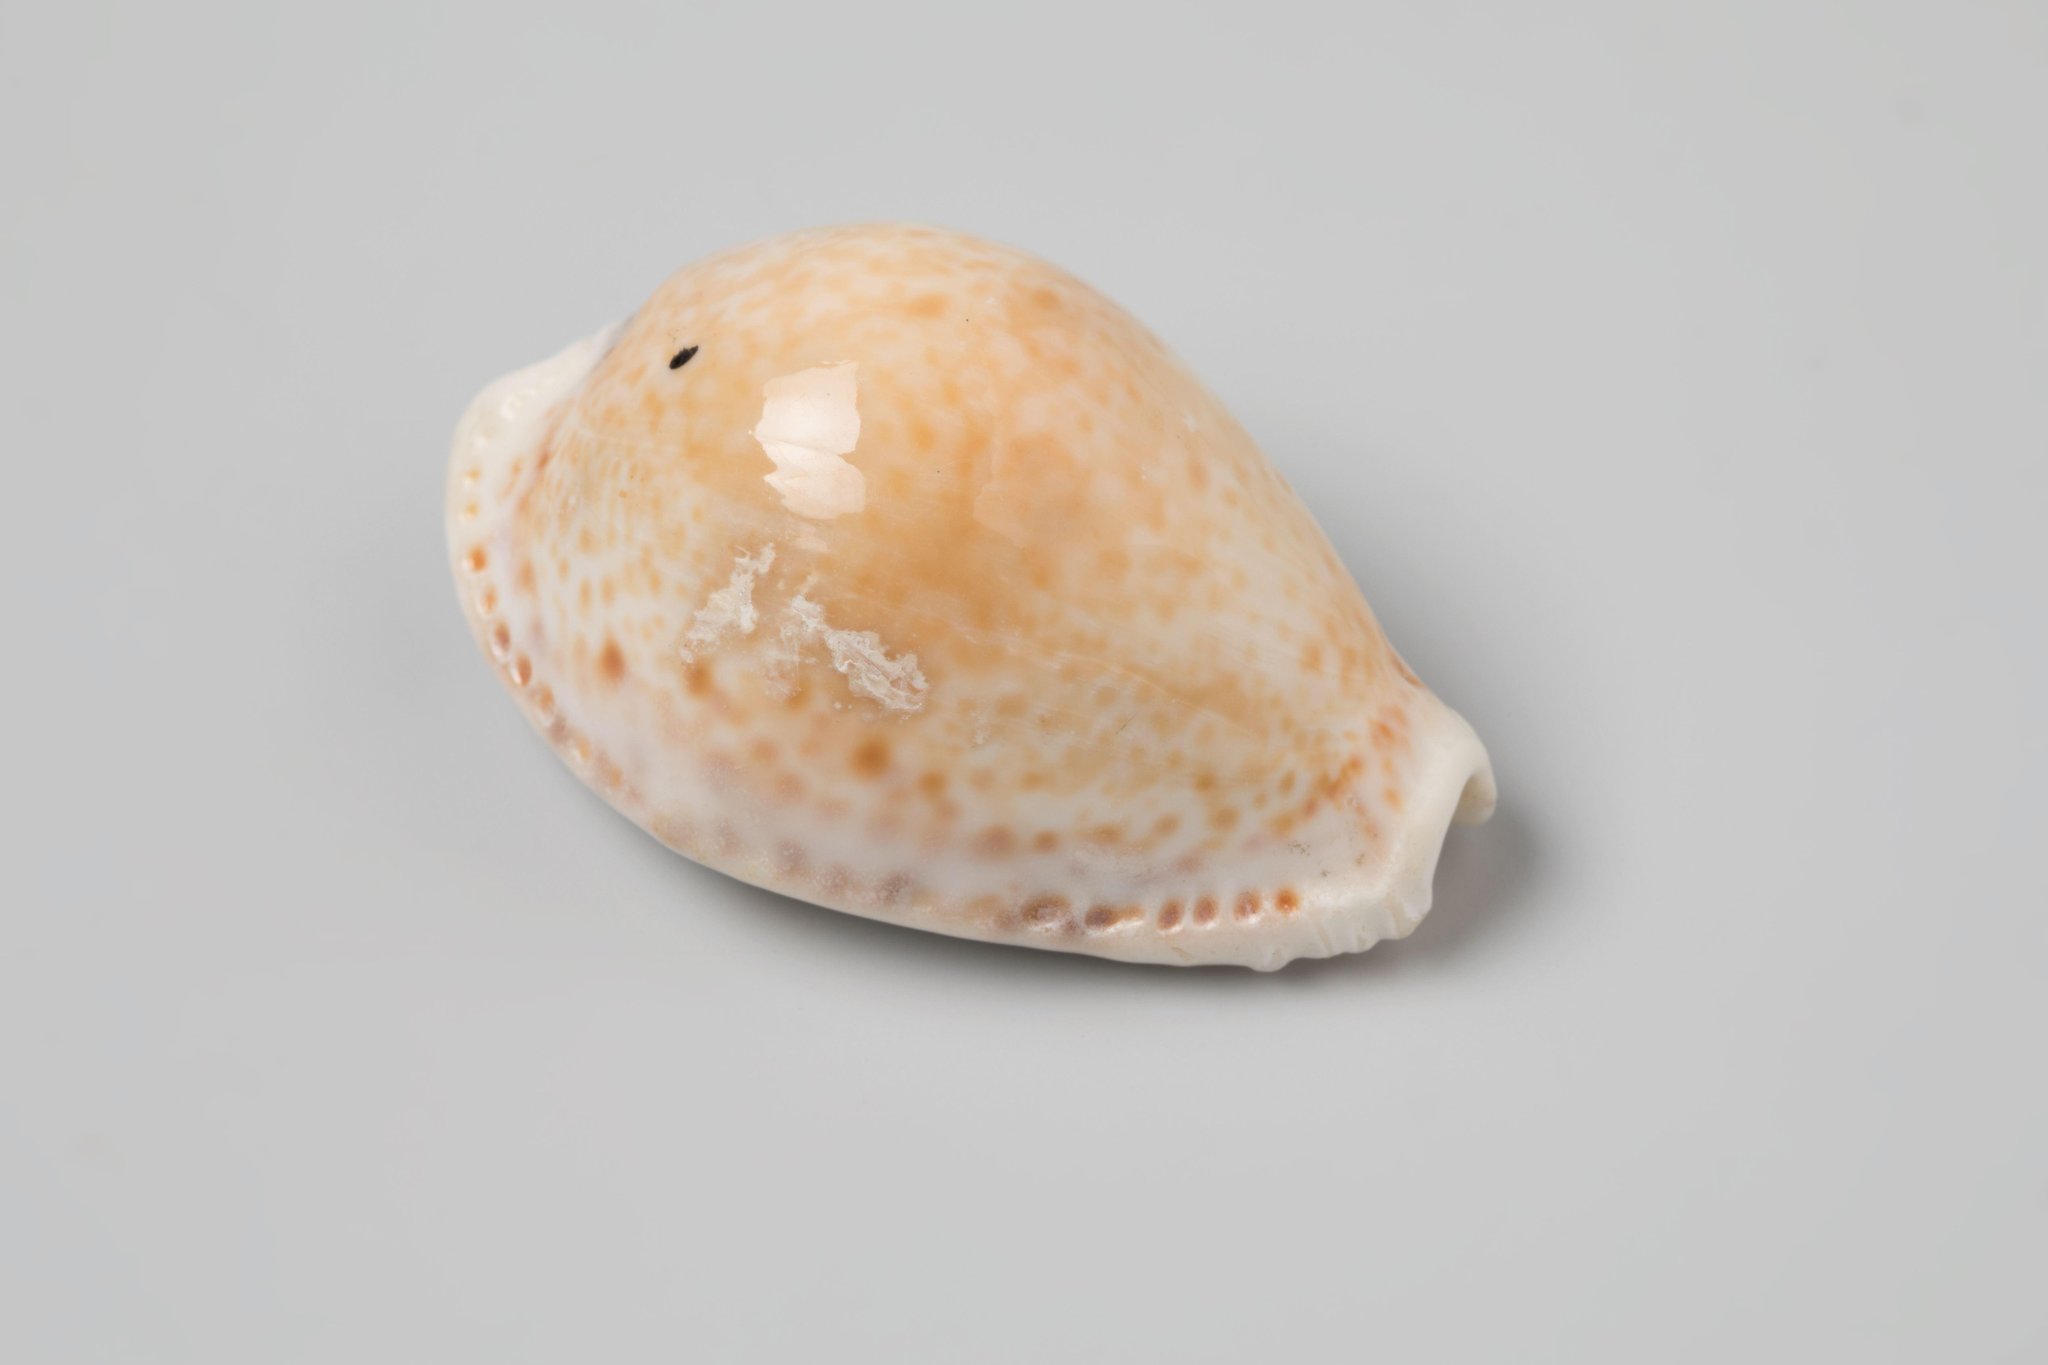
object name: erosaria spurca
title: Erosaria spurca shell from the wreck of the Dutch East India ship Witte Leeuw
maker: niet van toepassing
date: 1613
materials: shell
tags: verenigde oostindische compagnie, sint-helena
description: Schelp uit V.O.C.-schip de 'Witte Leeuw'.